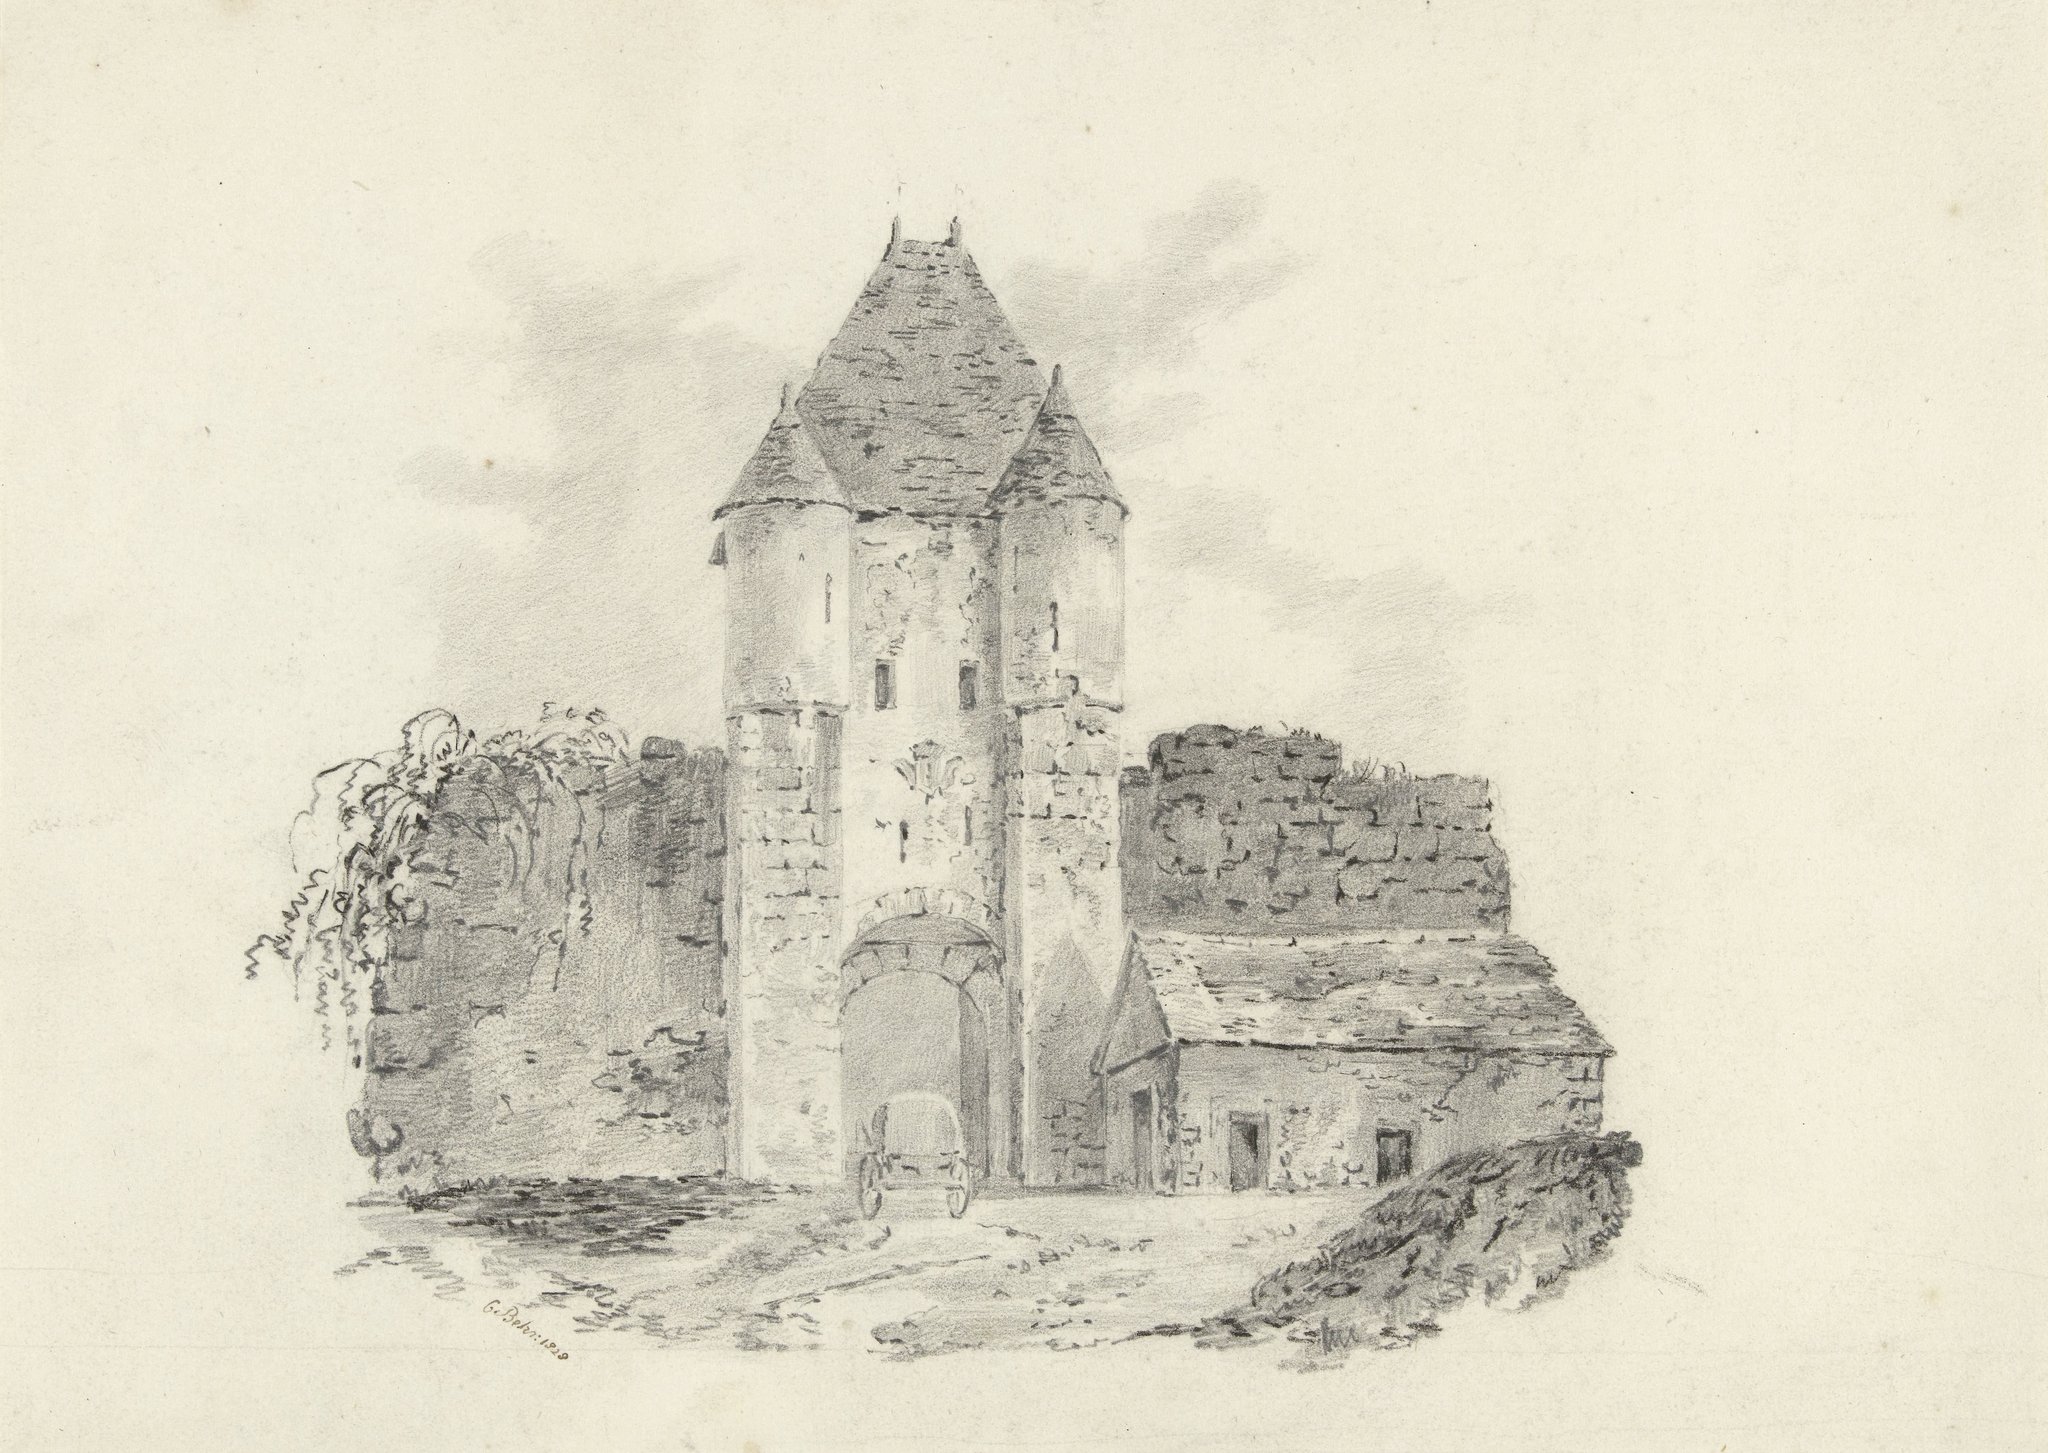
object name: drawing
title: Poortgebouw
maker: carel jacobus behr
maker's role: draughtsman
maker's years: 1812-1895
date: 1828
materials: chalk, paper, pencil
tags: city-gate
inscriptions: date: ‘1828’